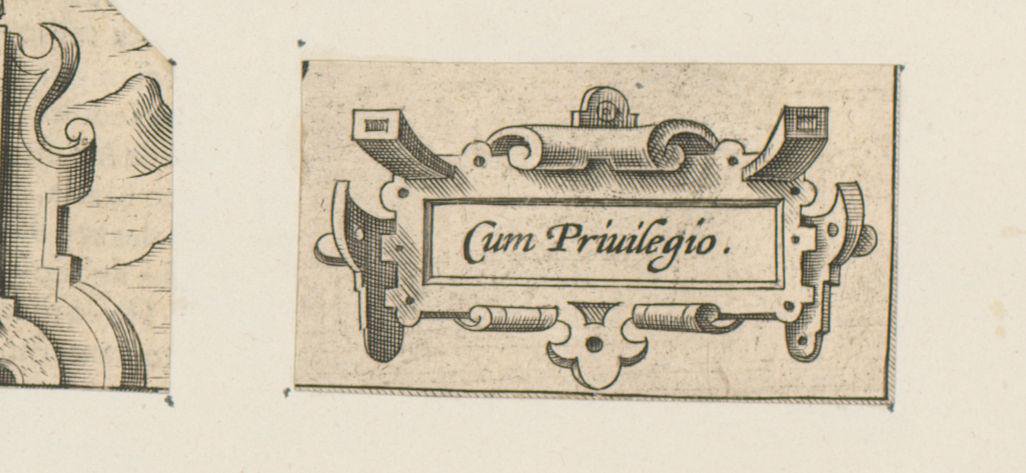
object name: ornament print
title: Cartouche van een kaart van Cremona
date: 1579-1580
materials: paper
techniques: engraving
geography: antwerp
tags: scrollwork, strapwork ~ ornament, ornament ~ cartouche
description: Kleine rechthoekige liggende cartouche met rolwerk. De cartouche is een fragment van een kaart van Cremona. De prent maakt deel uit van een album.